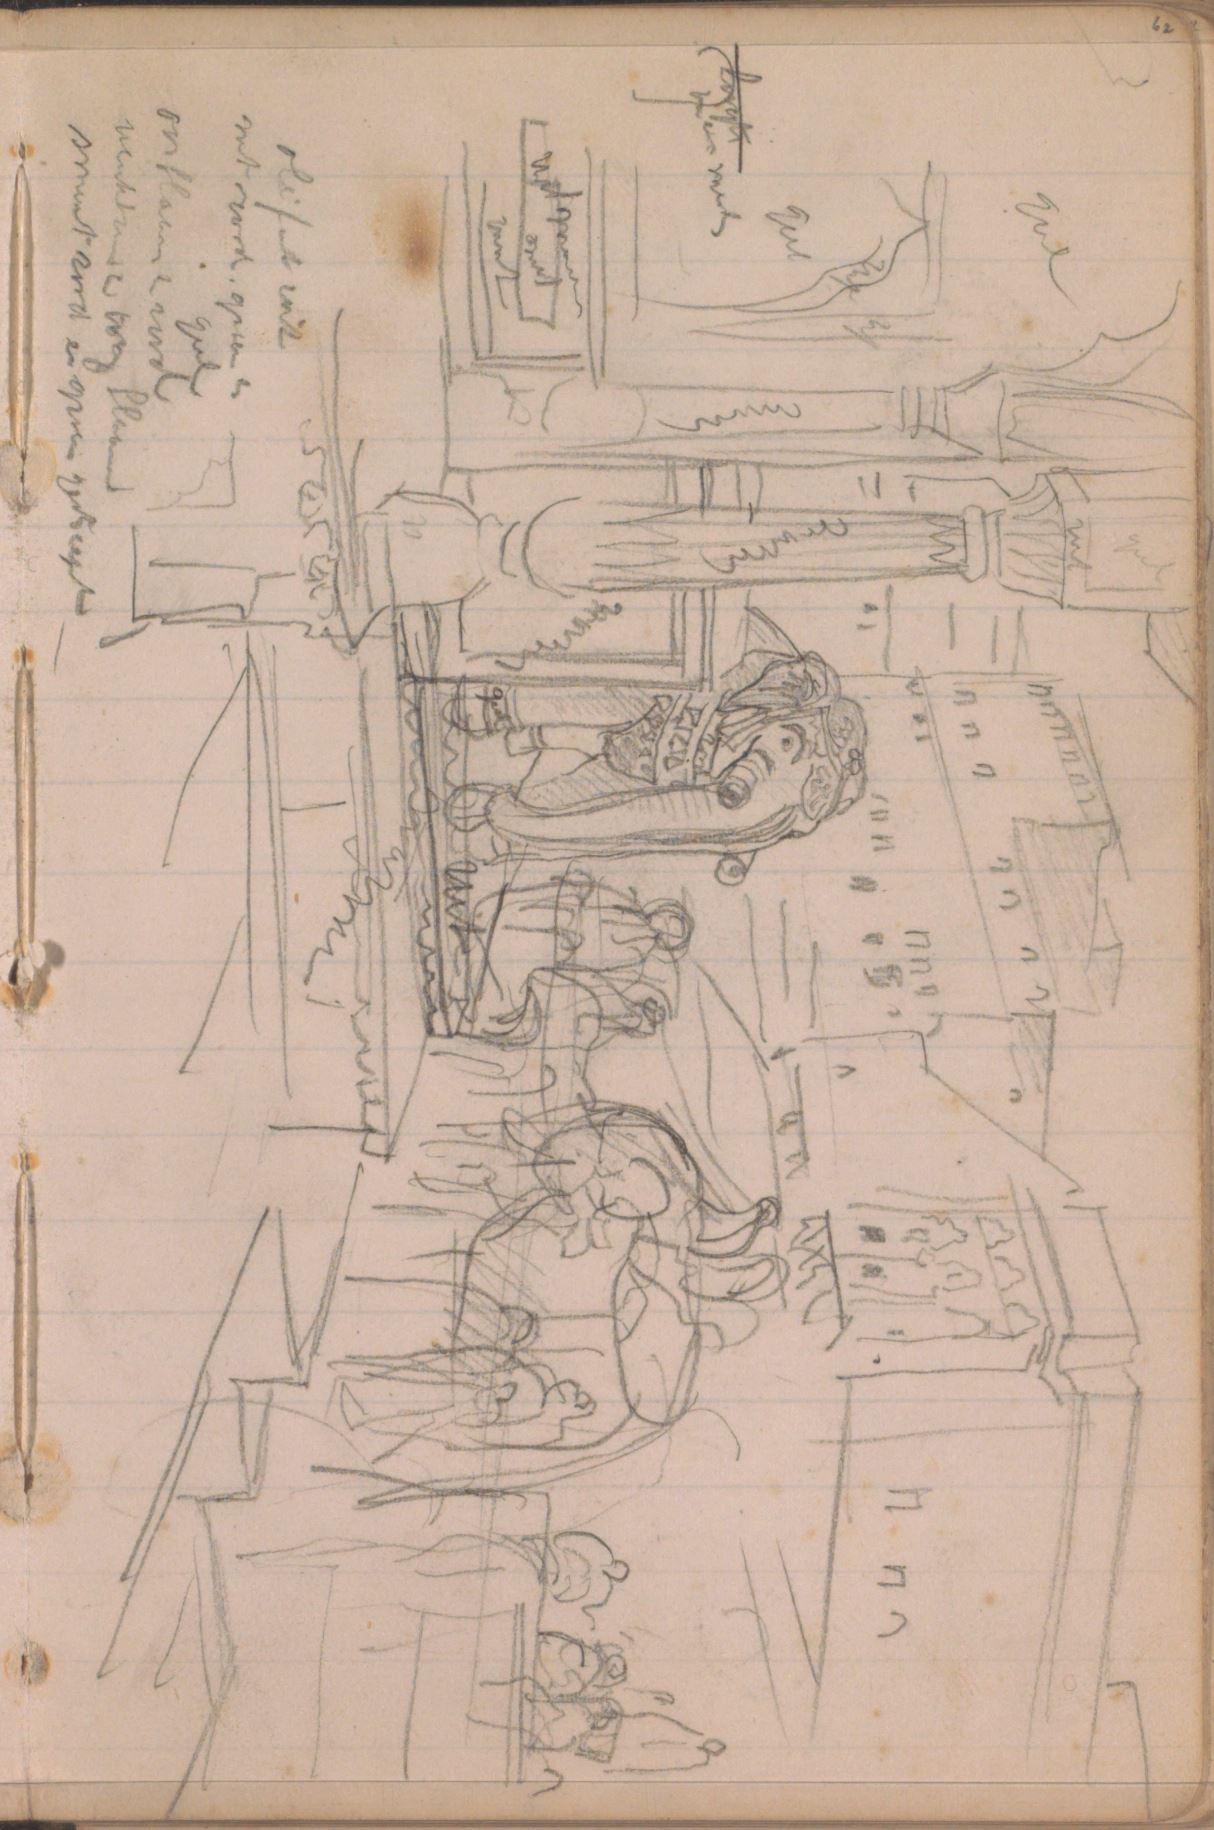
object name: sketchbook leaf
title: Straat met een beeld van een olifant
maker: marius bauer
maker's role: draughtsman, print maker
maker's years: 1867-1932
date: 1897-1898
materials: pencil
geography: india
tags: statues, paintings, etc. ~ objects of worship (hinduism, buddhism, jainism), street (+ city(-scape) with figures, staffage)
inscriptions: kleurnotitie, handgeschreven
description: Vermoedelijk is de olifant een voorwerp van aanbidding. Pagina 62 uit een schetsboek met 84 bladen.